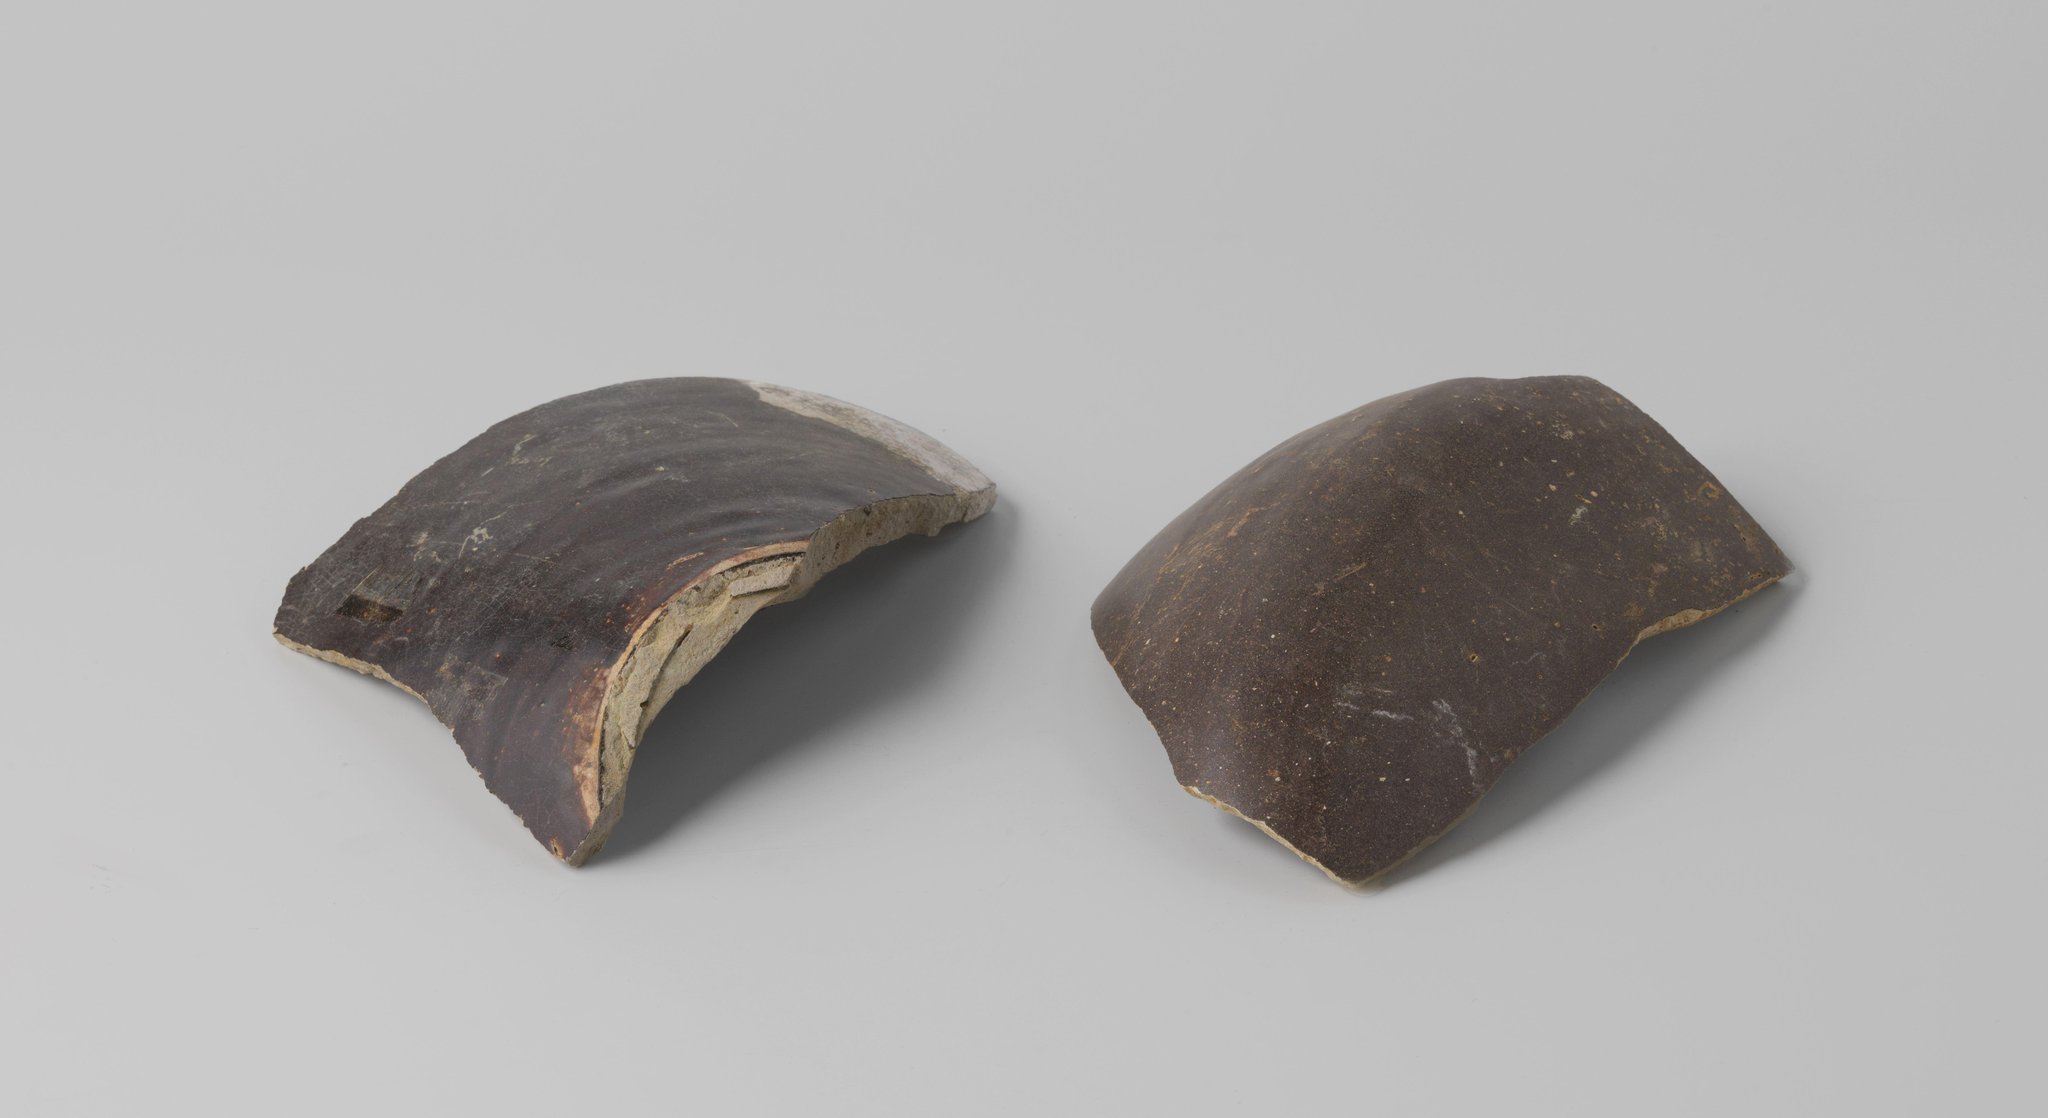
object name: martavaan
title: Scherven van martavanen uit V.O.C.-schip de 'Witte Leeuw'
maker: Anonymous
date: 1613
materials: porcelain, stoneware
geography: southeast asia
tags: verenigde oostindische compagnie, sint-helena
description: A jar. This exceptional jar has a wide waist and narrows towards the neck which ends in a narrow flaring mouth. The thin, double walled base has bursted open. The grey coloured clay contains few impurities. There are no traces of glaze on the outside or inside. It ha possibly been covered with a glaze or a slip. The upper half of the exterior has concentric grooves neatly incised from the neck to the waist.